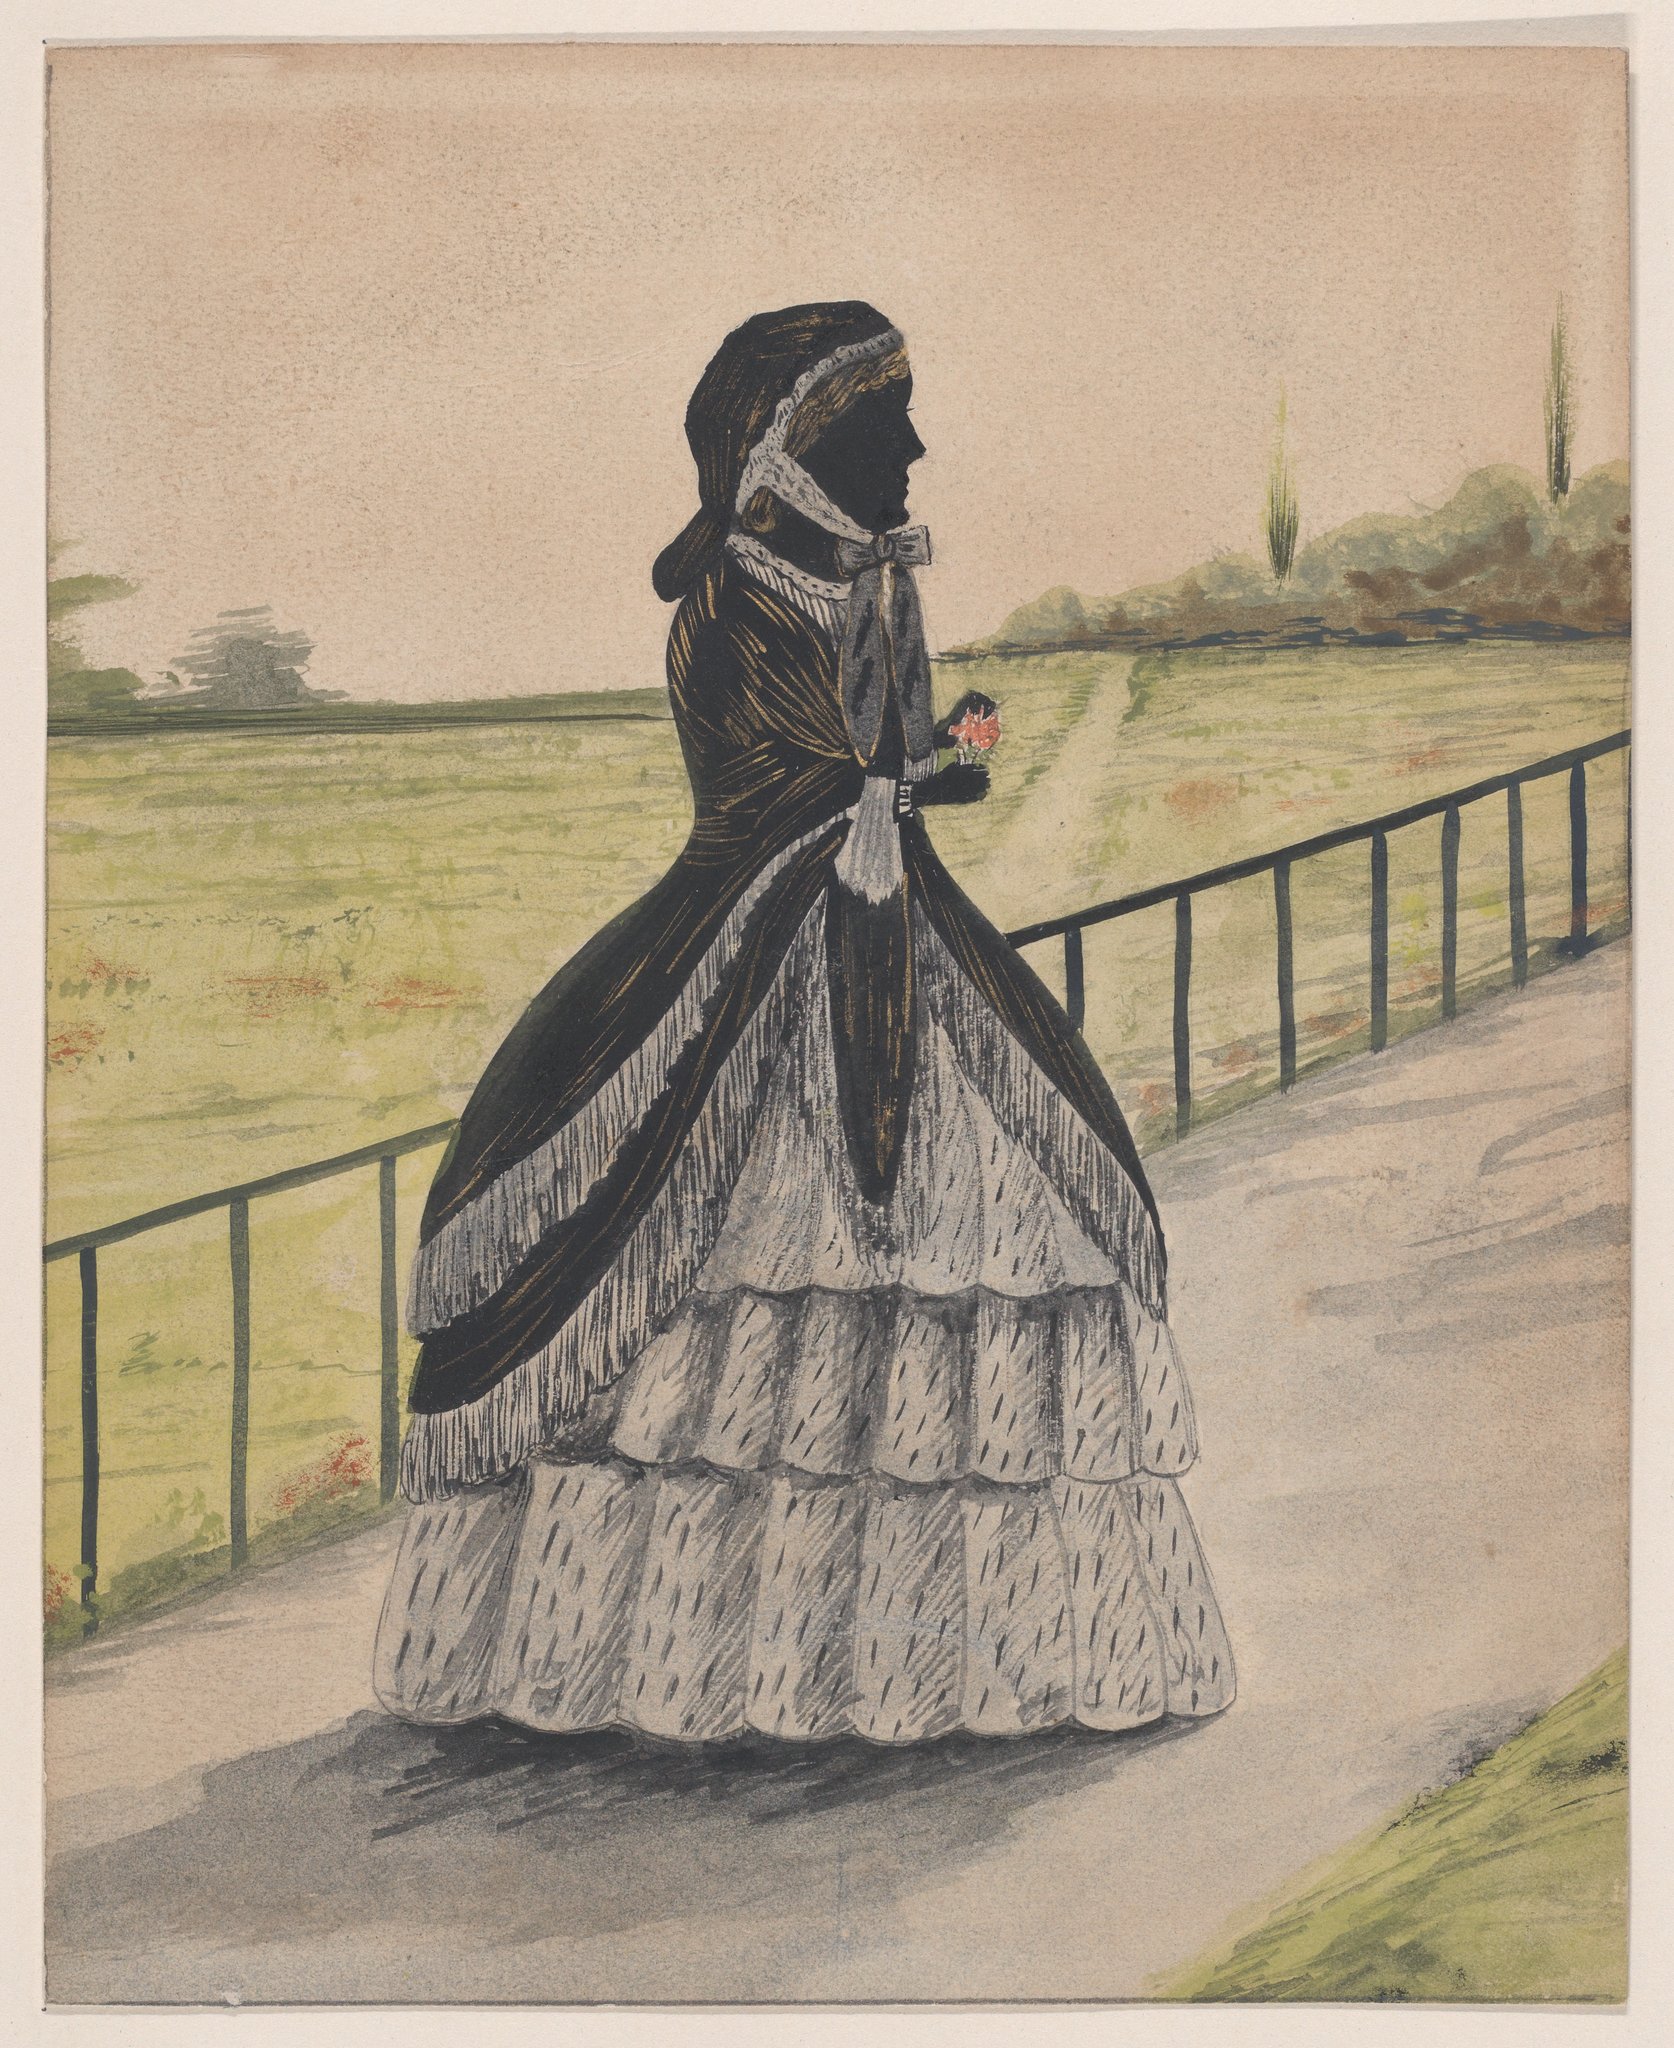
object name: drawing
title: Silhouette of Lady Carstairs, Hyde Park, London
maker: Anonymous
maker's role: artist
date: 1801-1900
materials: gouache, ink, watercolor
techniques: brush, pen, wash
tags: women